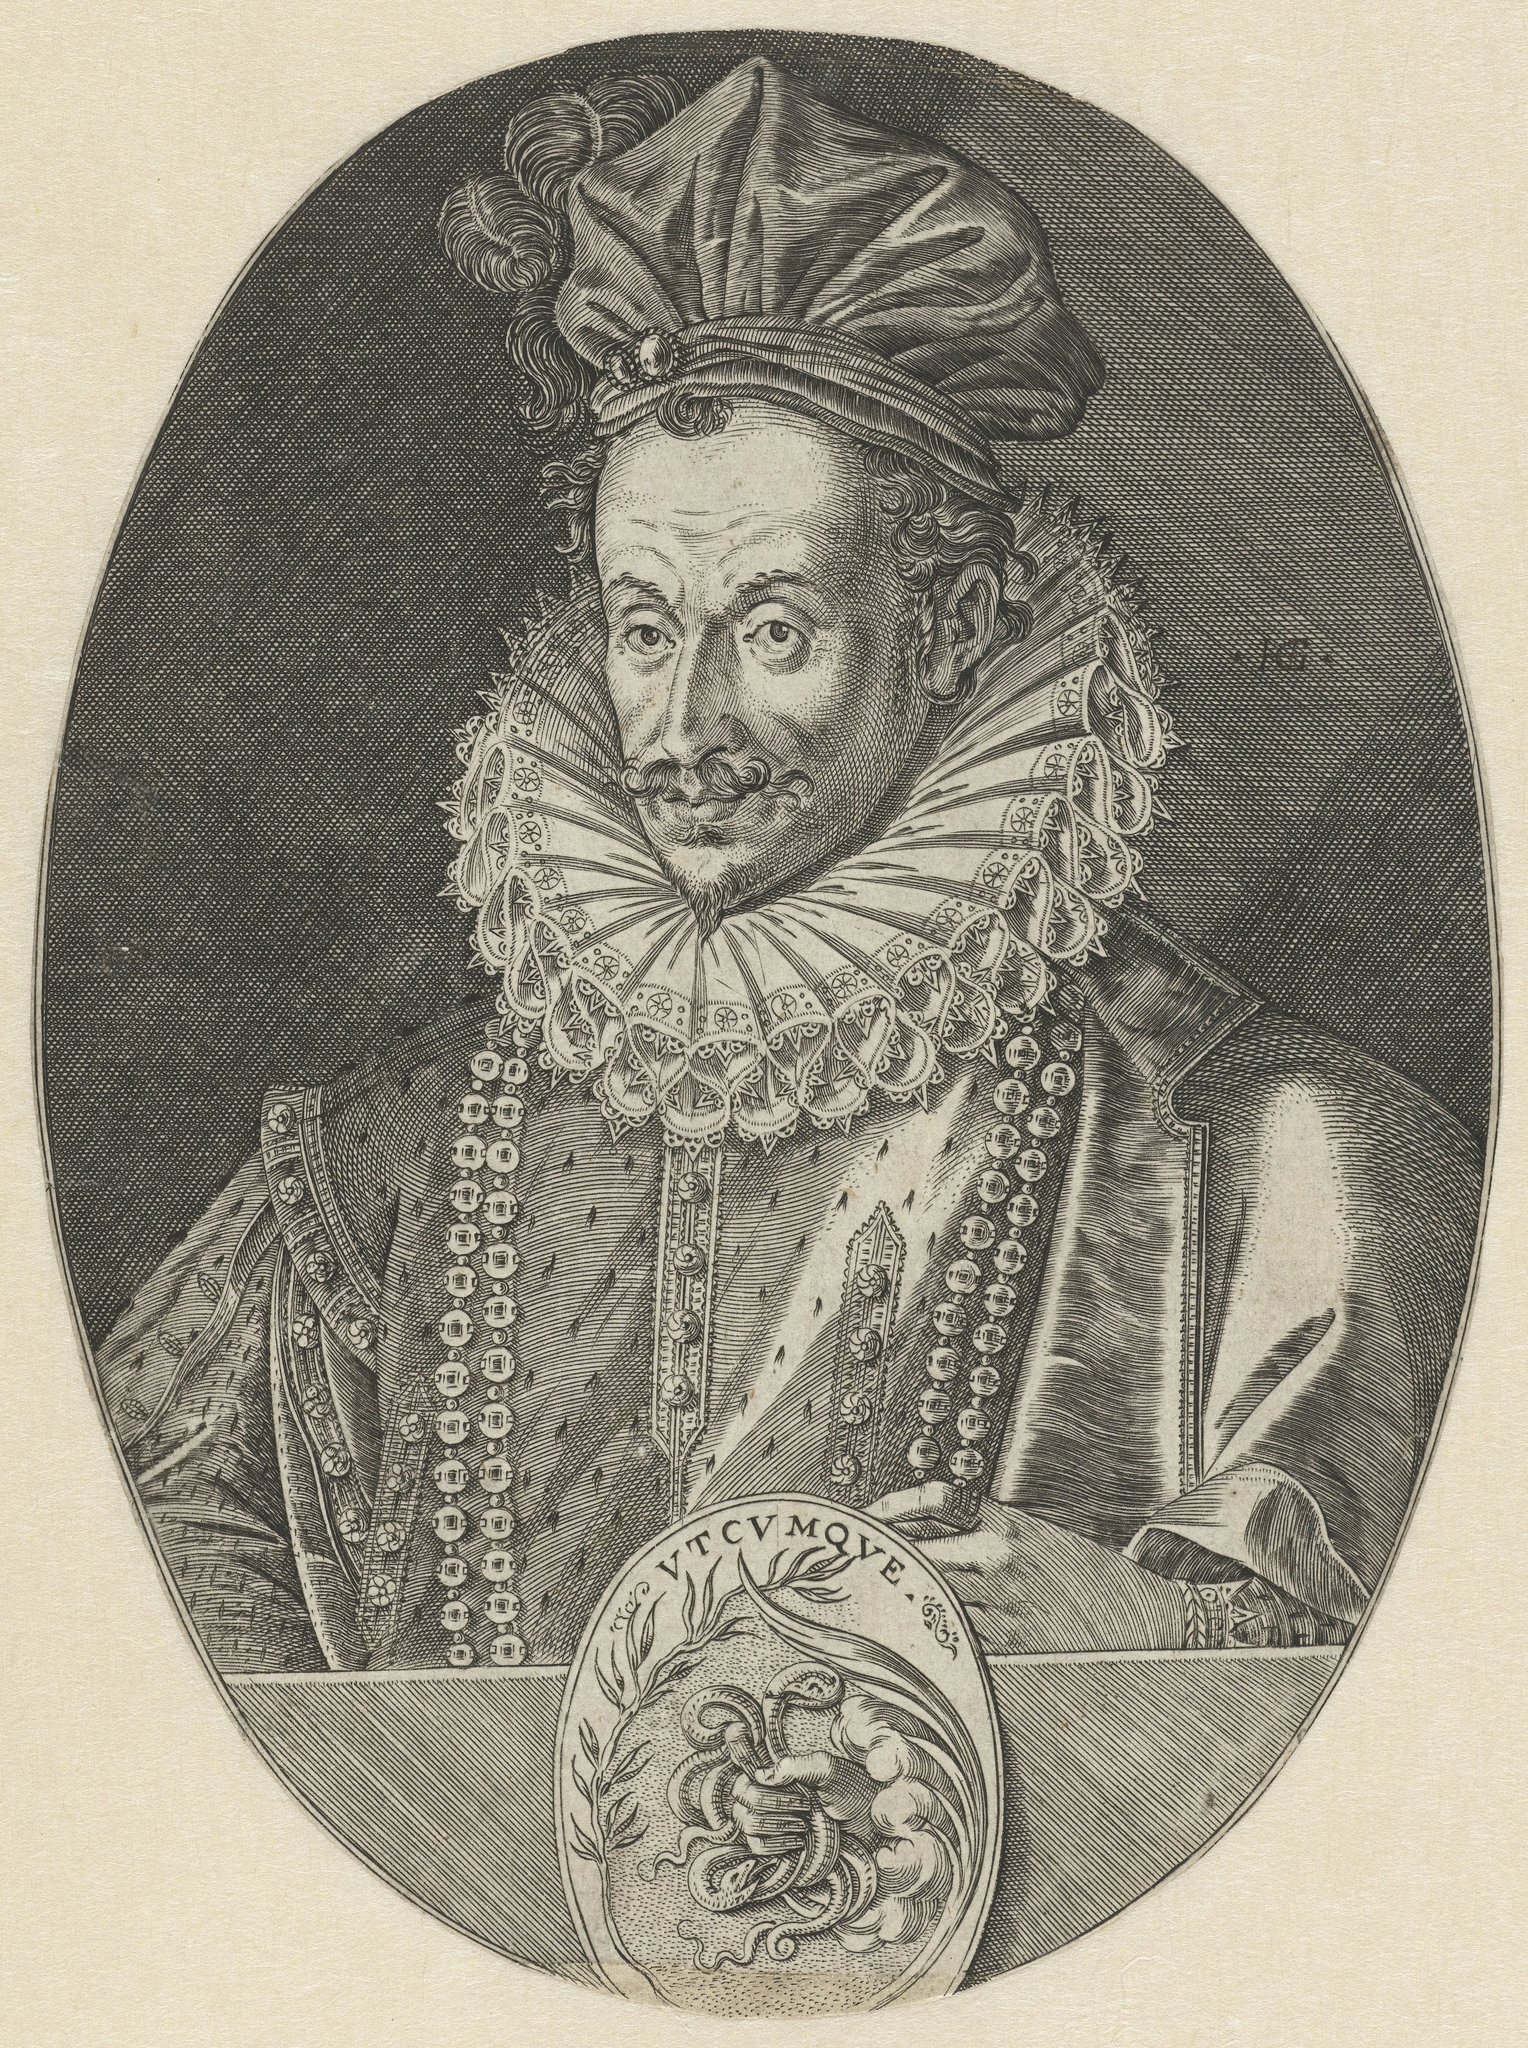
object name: print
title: Portret van een edelman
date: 1570-1615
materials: paper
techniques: engraving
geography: germany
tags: anonymous historical person portrayed alone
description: Portret ten halven lijve in ovaal van een deftig geklede heer, met brede geplooide kraag en muts met veren. Onderin de voorstelling een devies: het woord 'utcumque' en een hand die een aantal slangen vasthoudt.